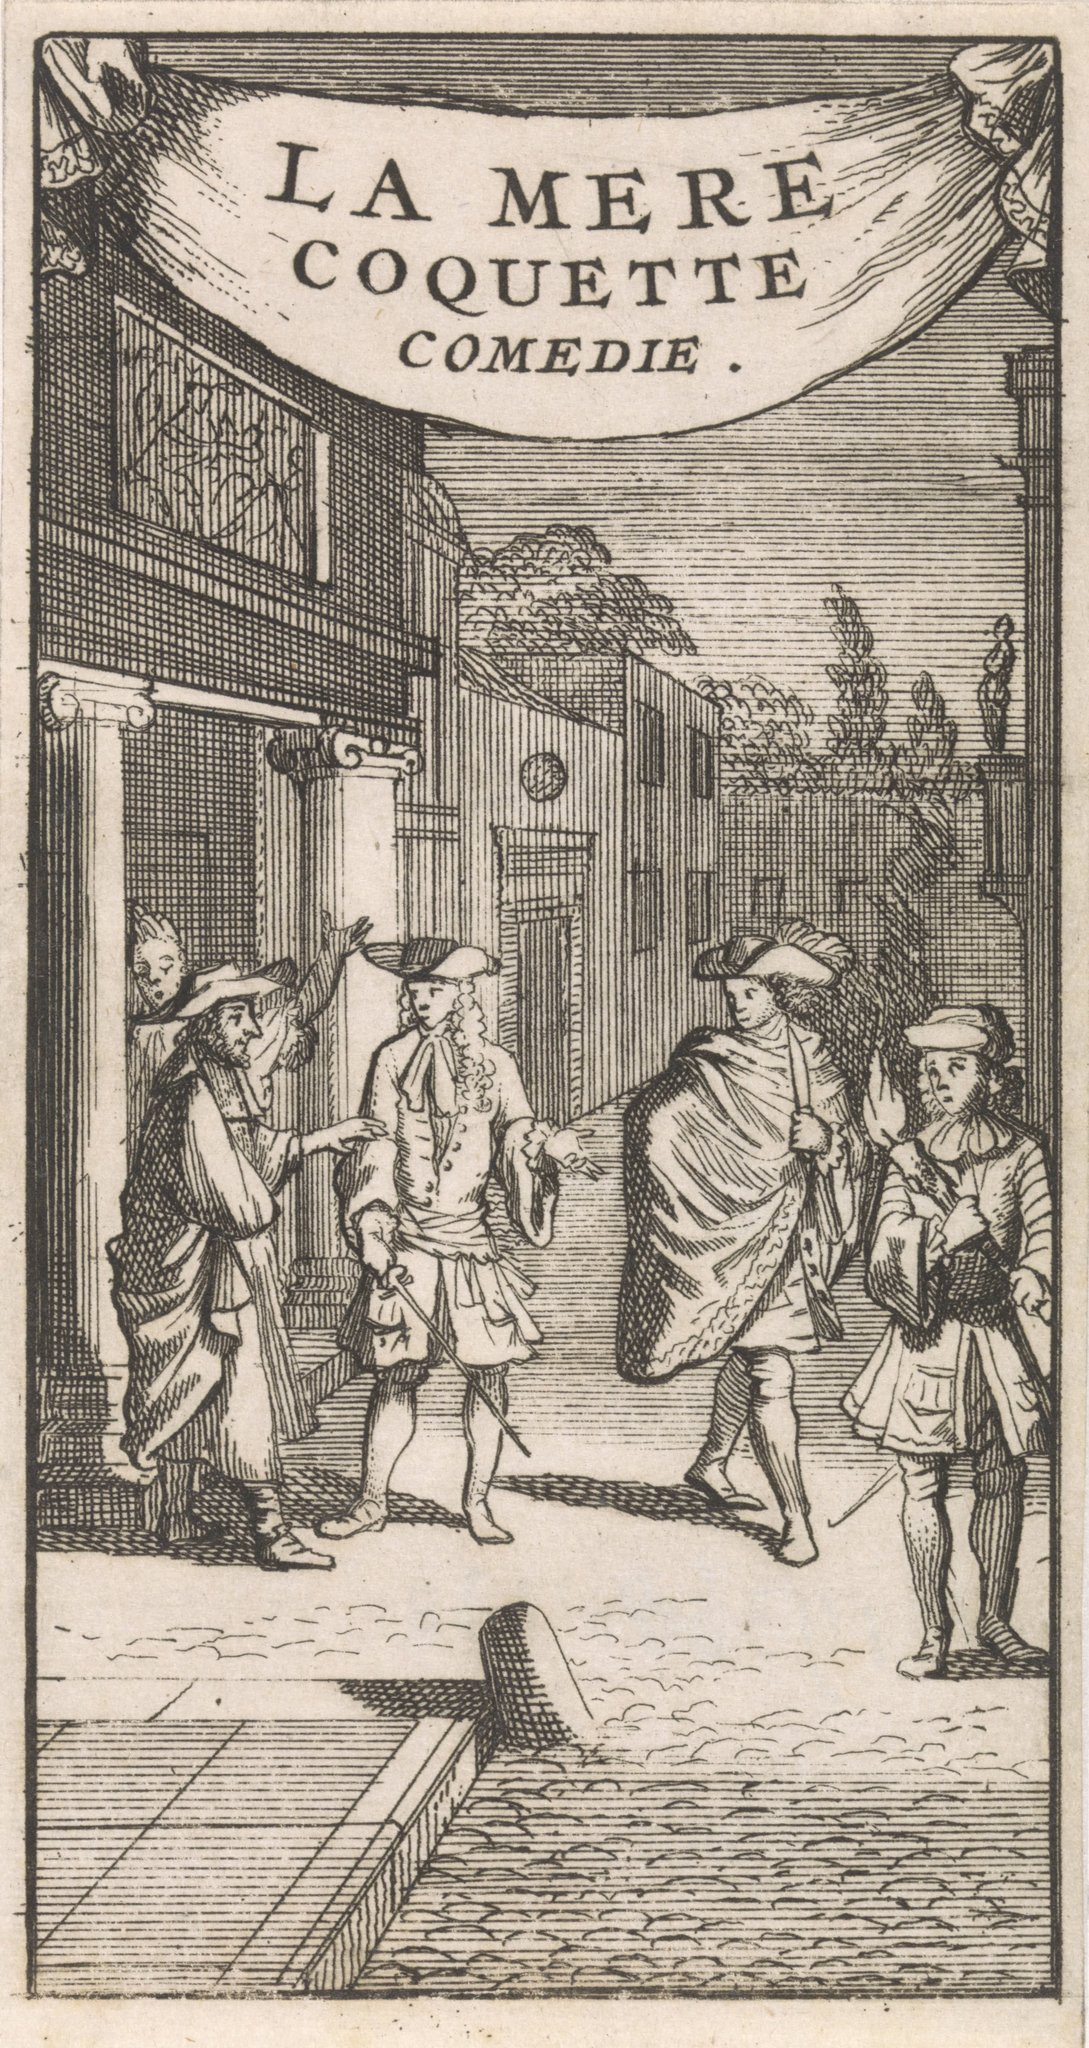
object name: print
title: Titelpagina voor "La Mere Coquette", in: P. Quinault, Le theatre, deel II, 1697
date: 1697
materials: paper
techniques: etching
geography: amsterdam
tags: before the street-fight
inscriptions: collector's mark: Lugt 2228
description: Titelpagina voor het toneelstuk "La Mere Coquette" in deel II van: Quinault, Philippe. Le theatre, 2 delen. Amsterdam: Antoine Schelte, 1697.